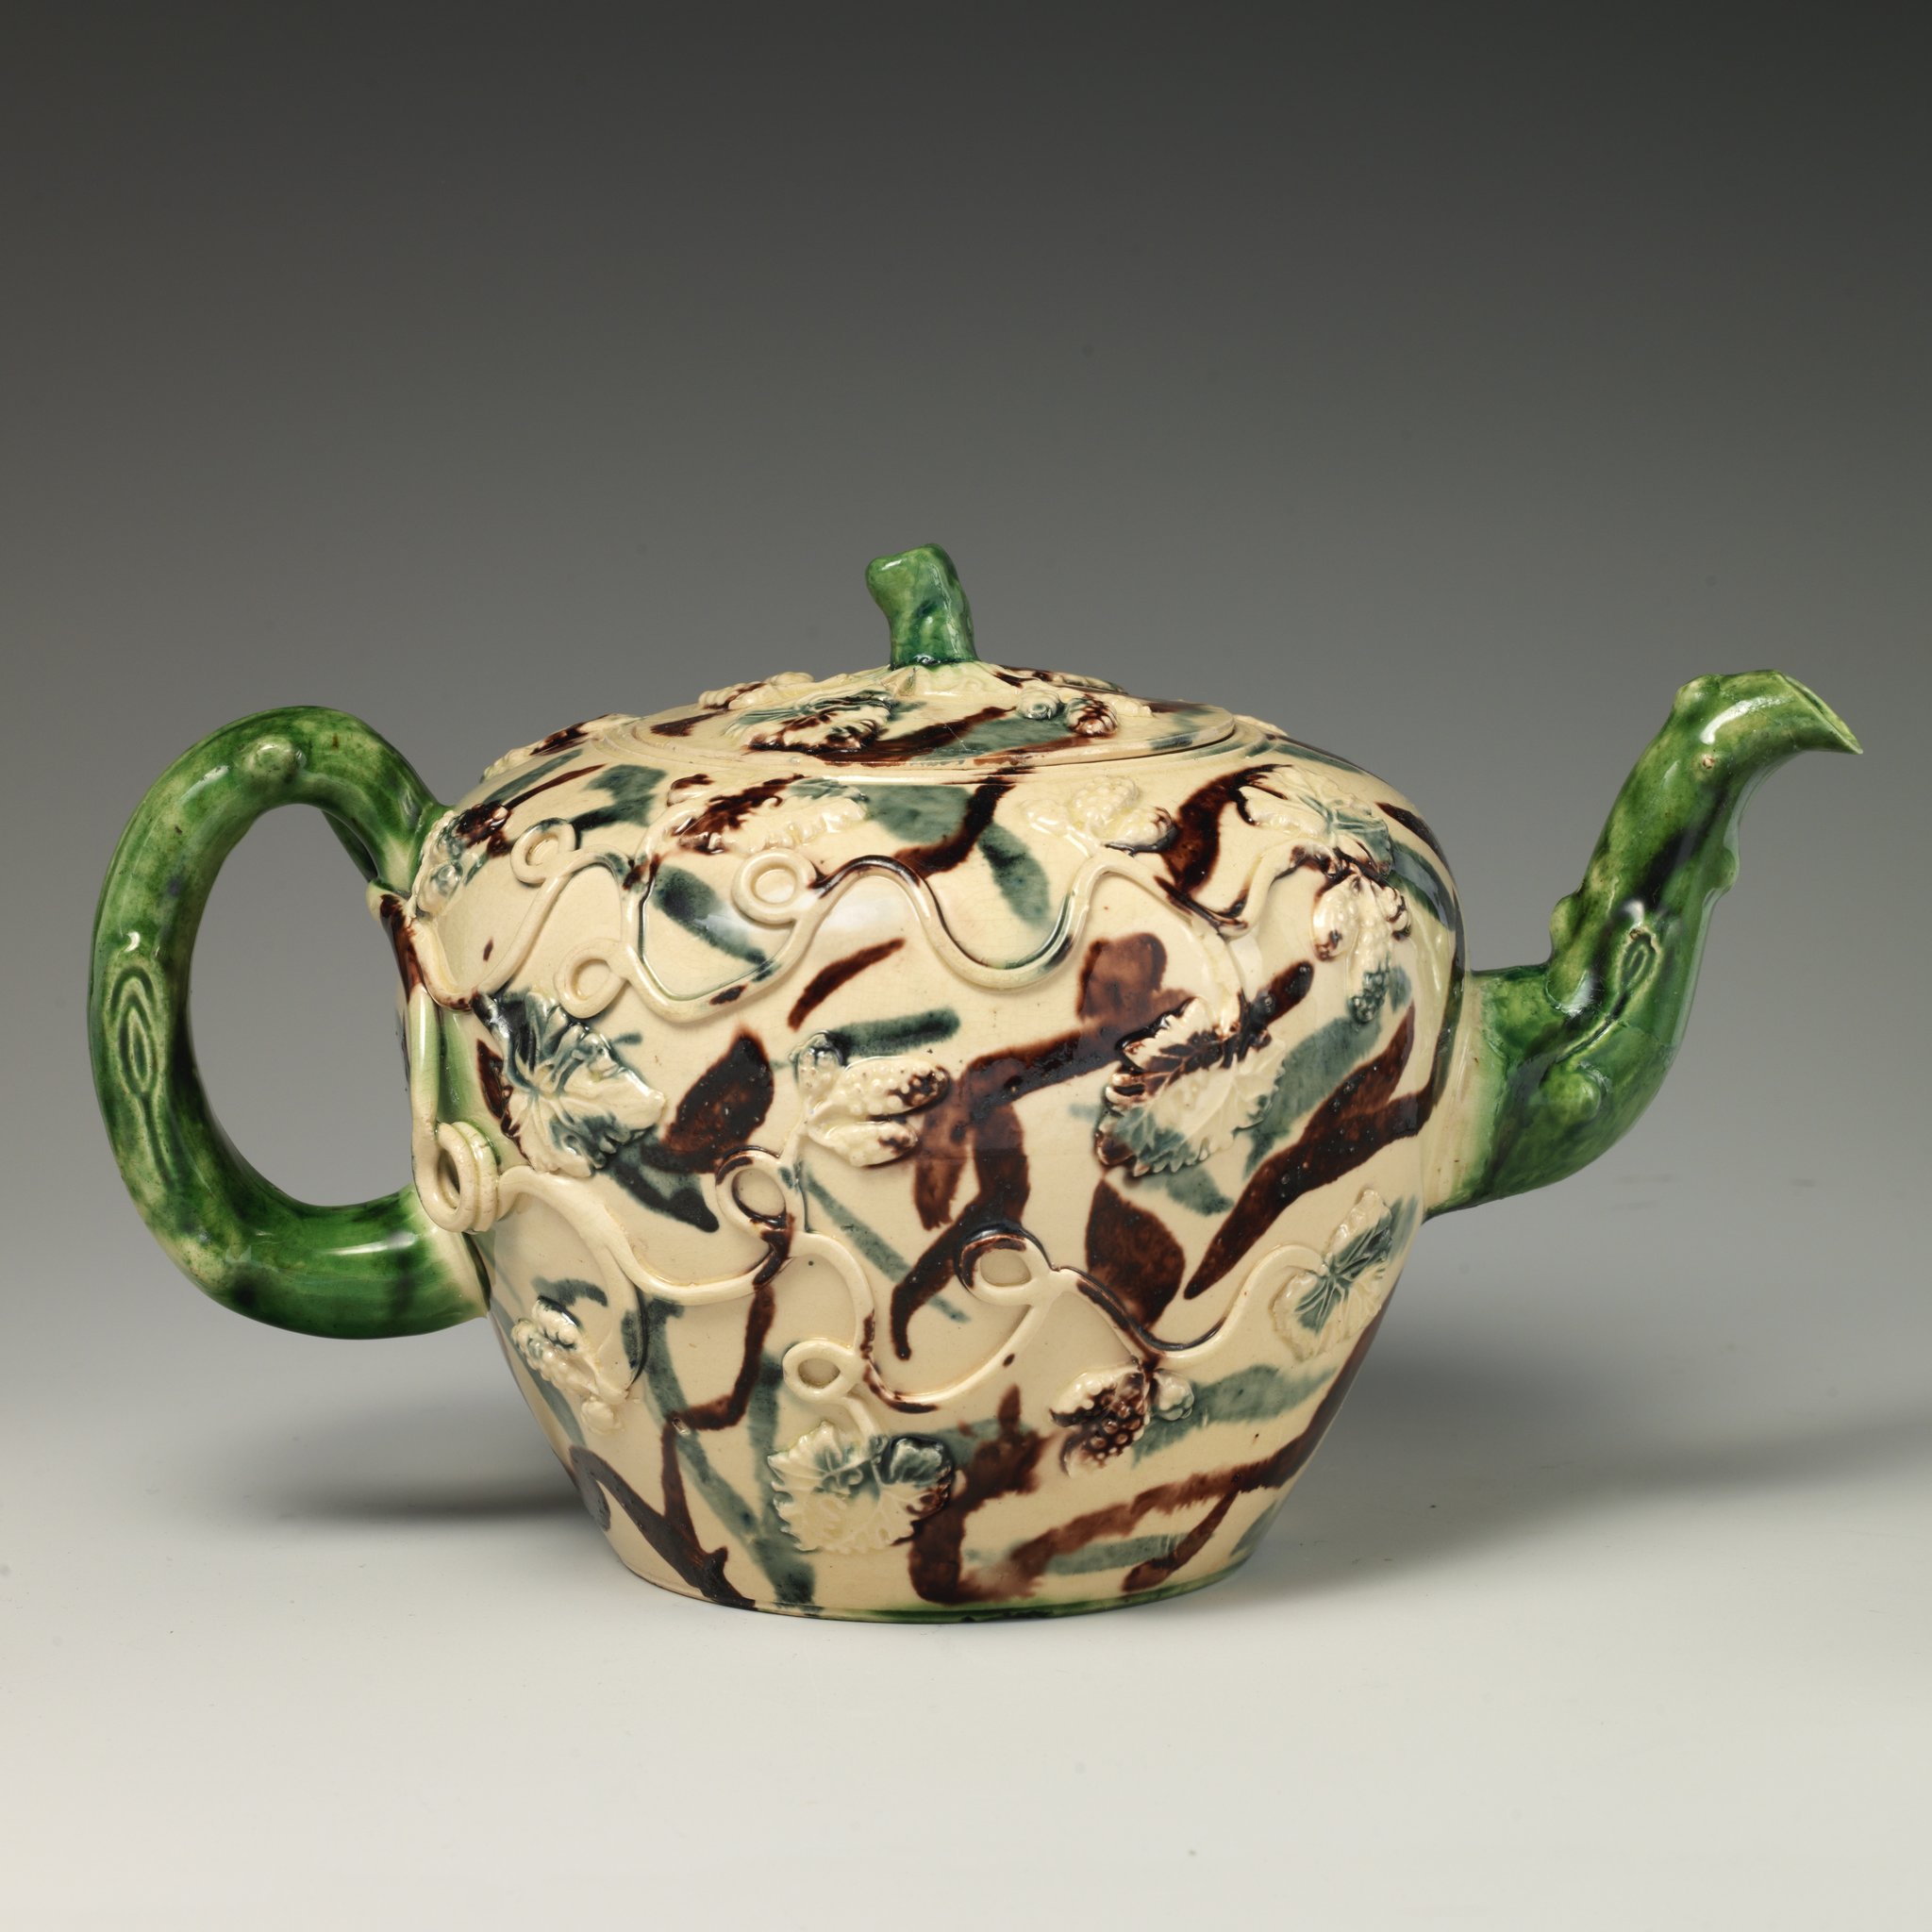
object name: teapot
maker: astbury-whieldon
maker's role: maker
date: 1750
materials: earthenware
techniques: glazing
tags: leaves